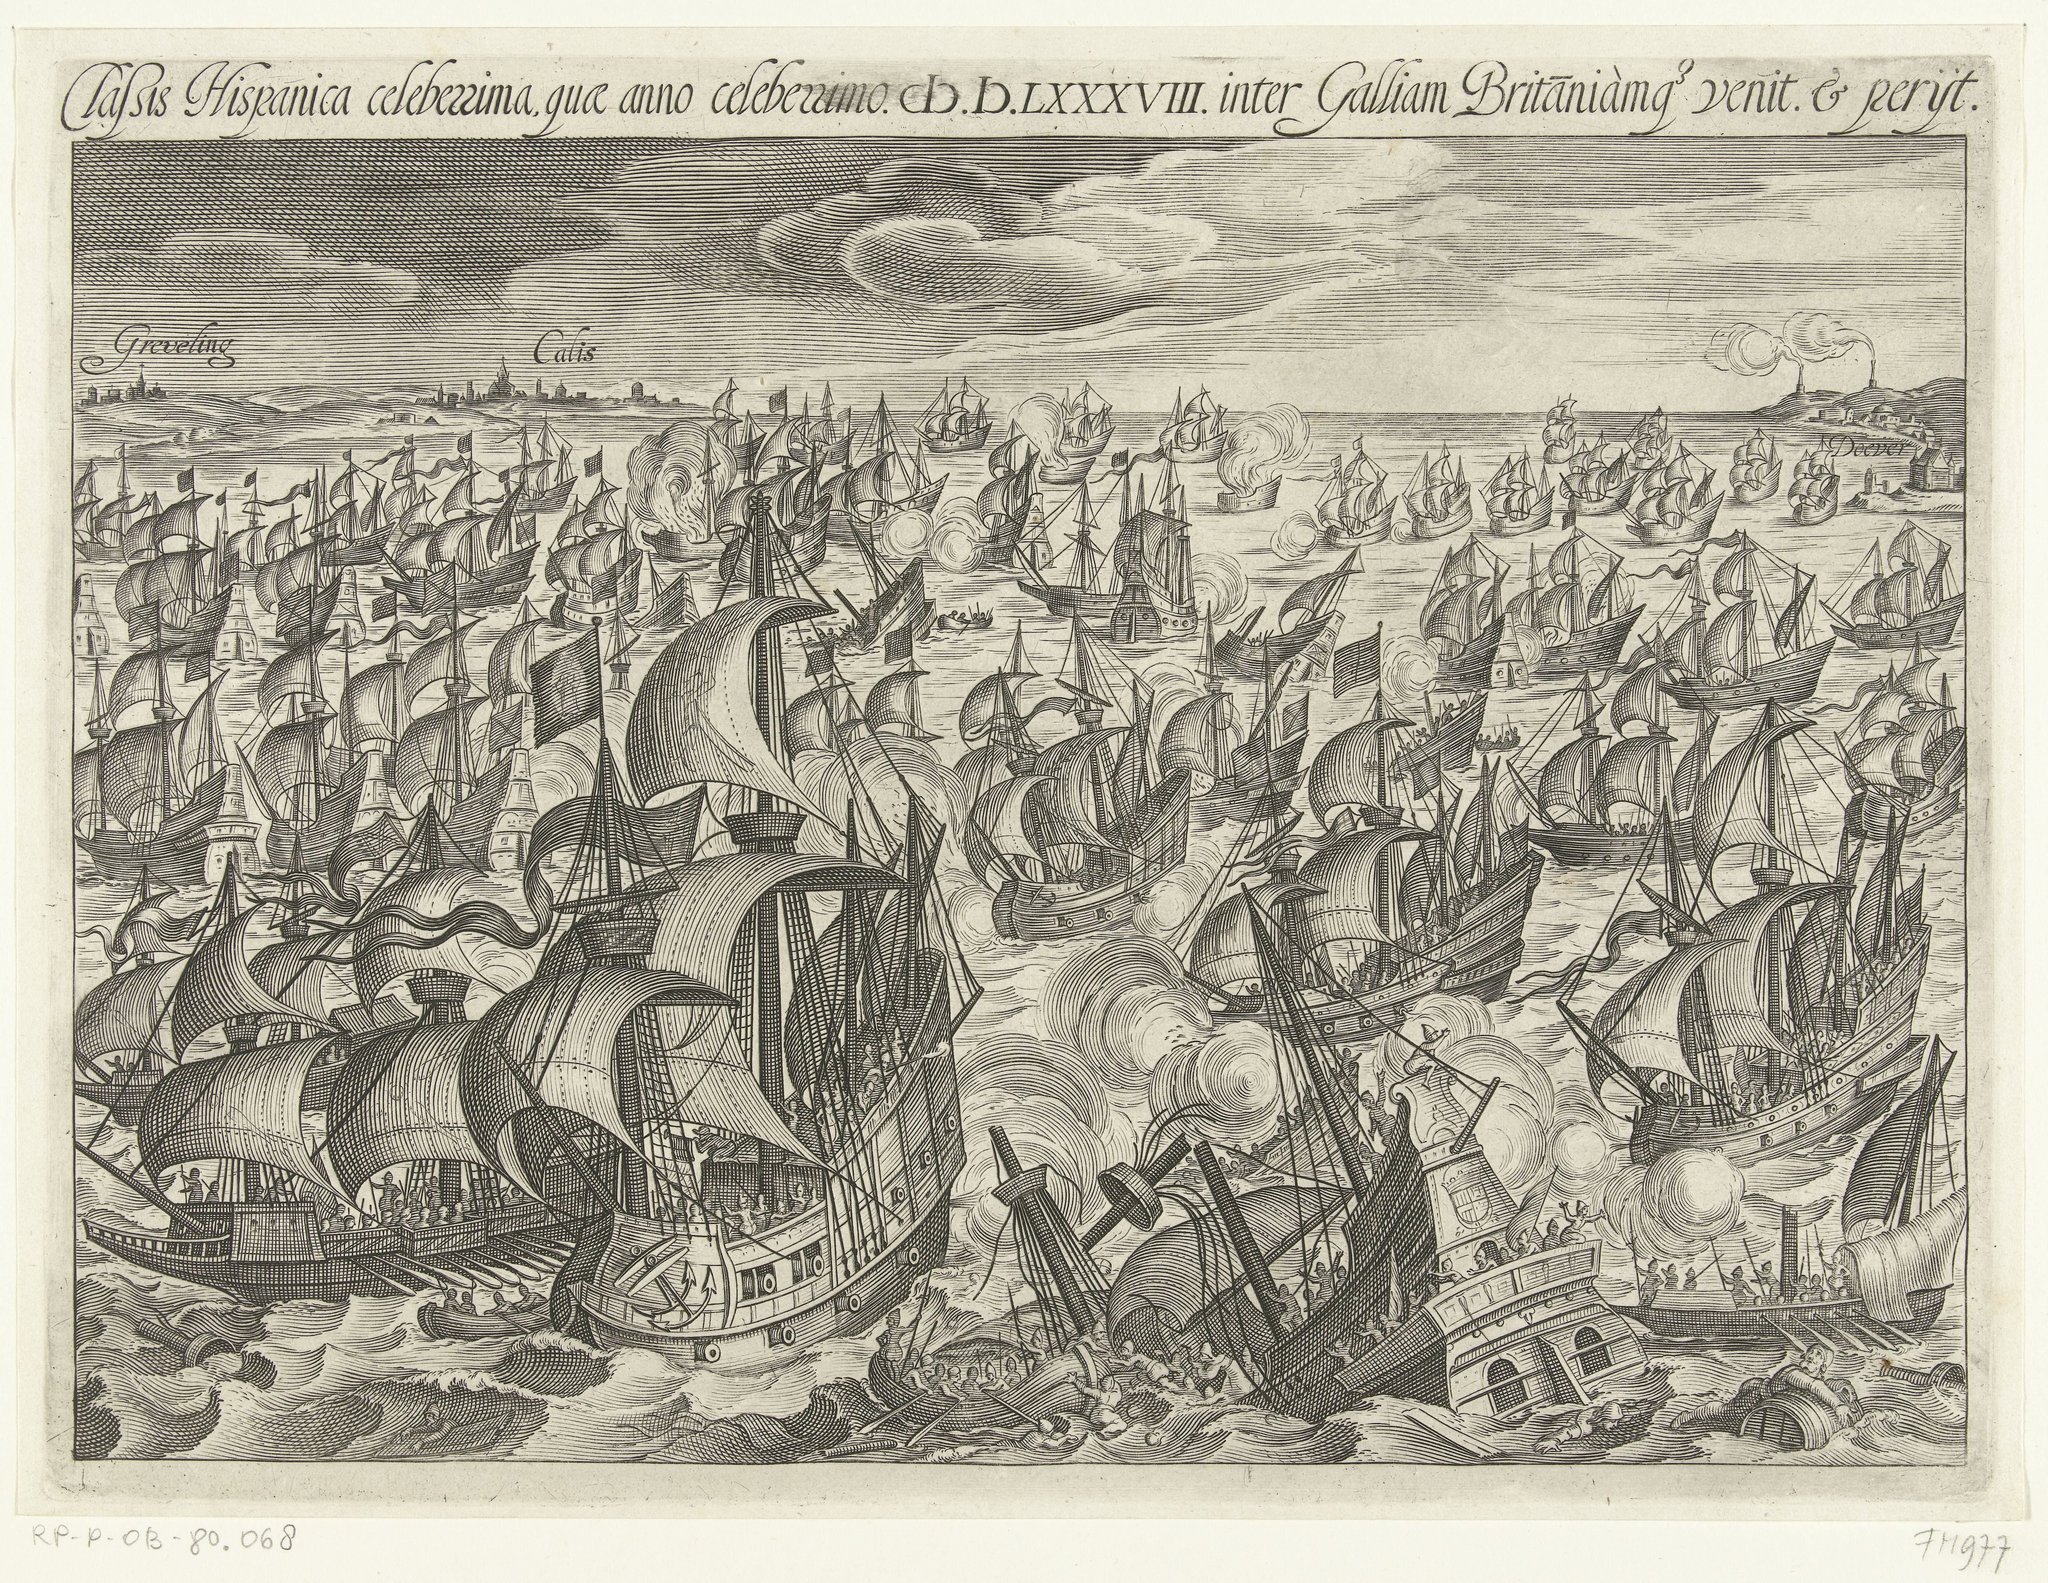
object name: print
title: Ondergang van de Spaanse Armada, 1588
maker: Anonymous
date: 1600-1601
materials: paper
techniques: engraving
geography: northern netherlands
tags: battle (+ naval force), english channel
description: Gebruikt als illustratie in: J.J. Orlers, Den Nassauschen Lauren-Crans: Beschrijvinghe ende af-beeldinge van alle de victorien ... die Godt Almachtich de ... Staten der Vereenichde Nederlanden verleent heeft, deur het wijs ende clouck beleyt des Hooch-ghebooren Fursts Maurits van Nassau, J.J. Orlers en H. van Haestens, Leiden 1610, fol. 34/35.